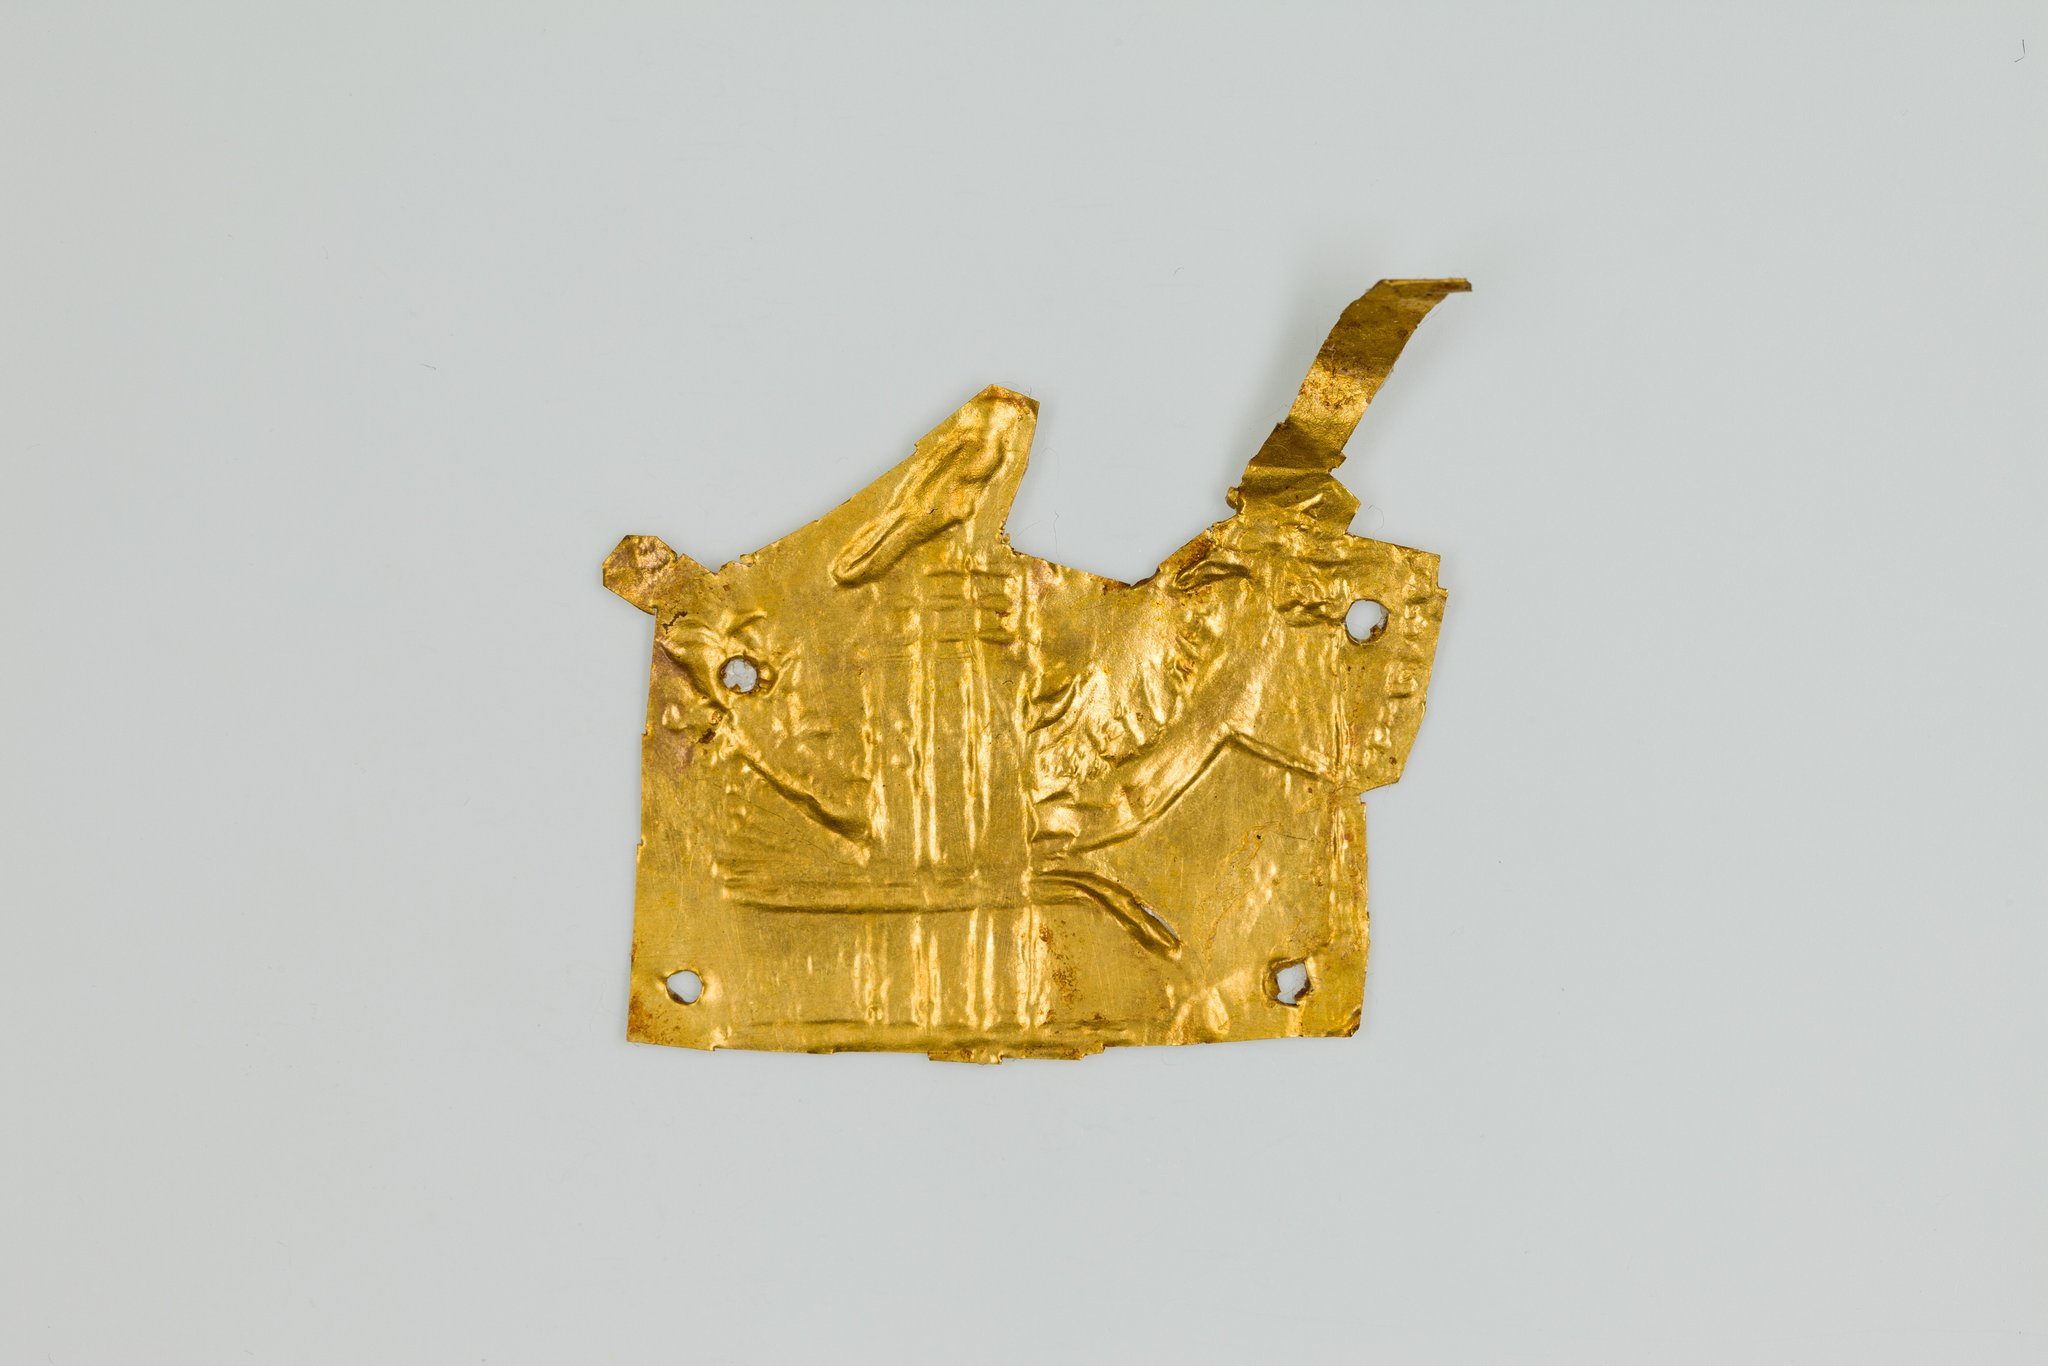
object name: amulet, henu barque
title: Henu barque amulet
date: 664-380 BCE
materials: gold